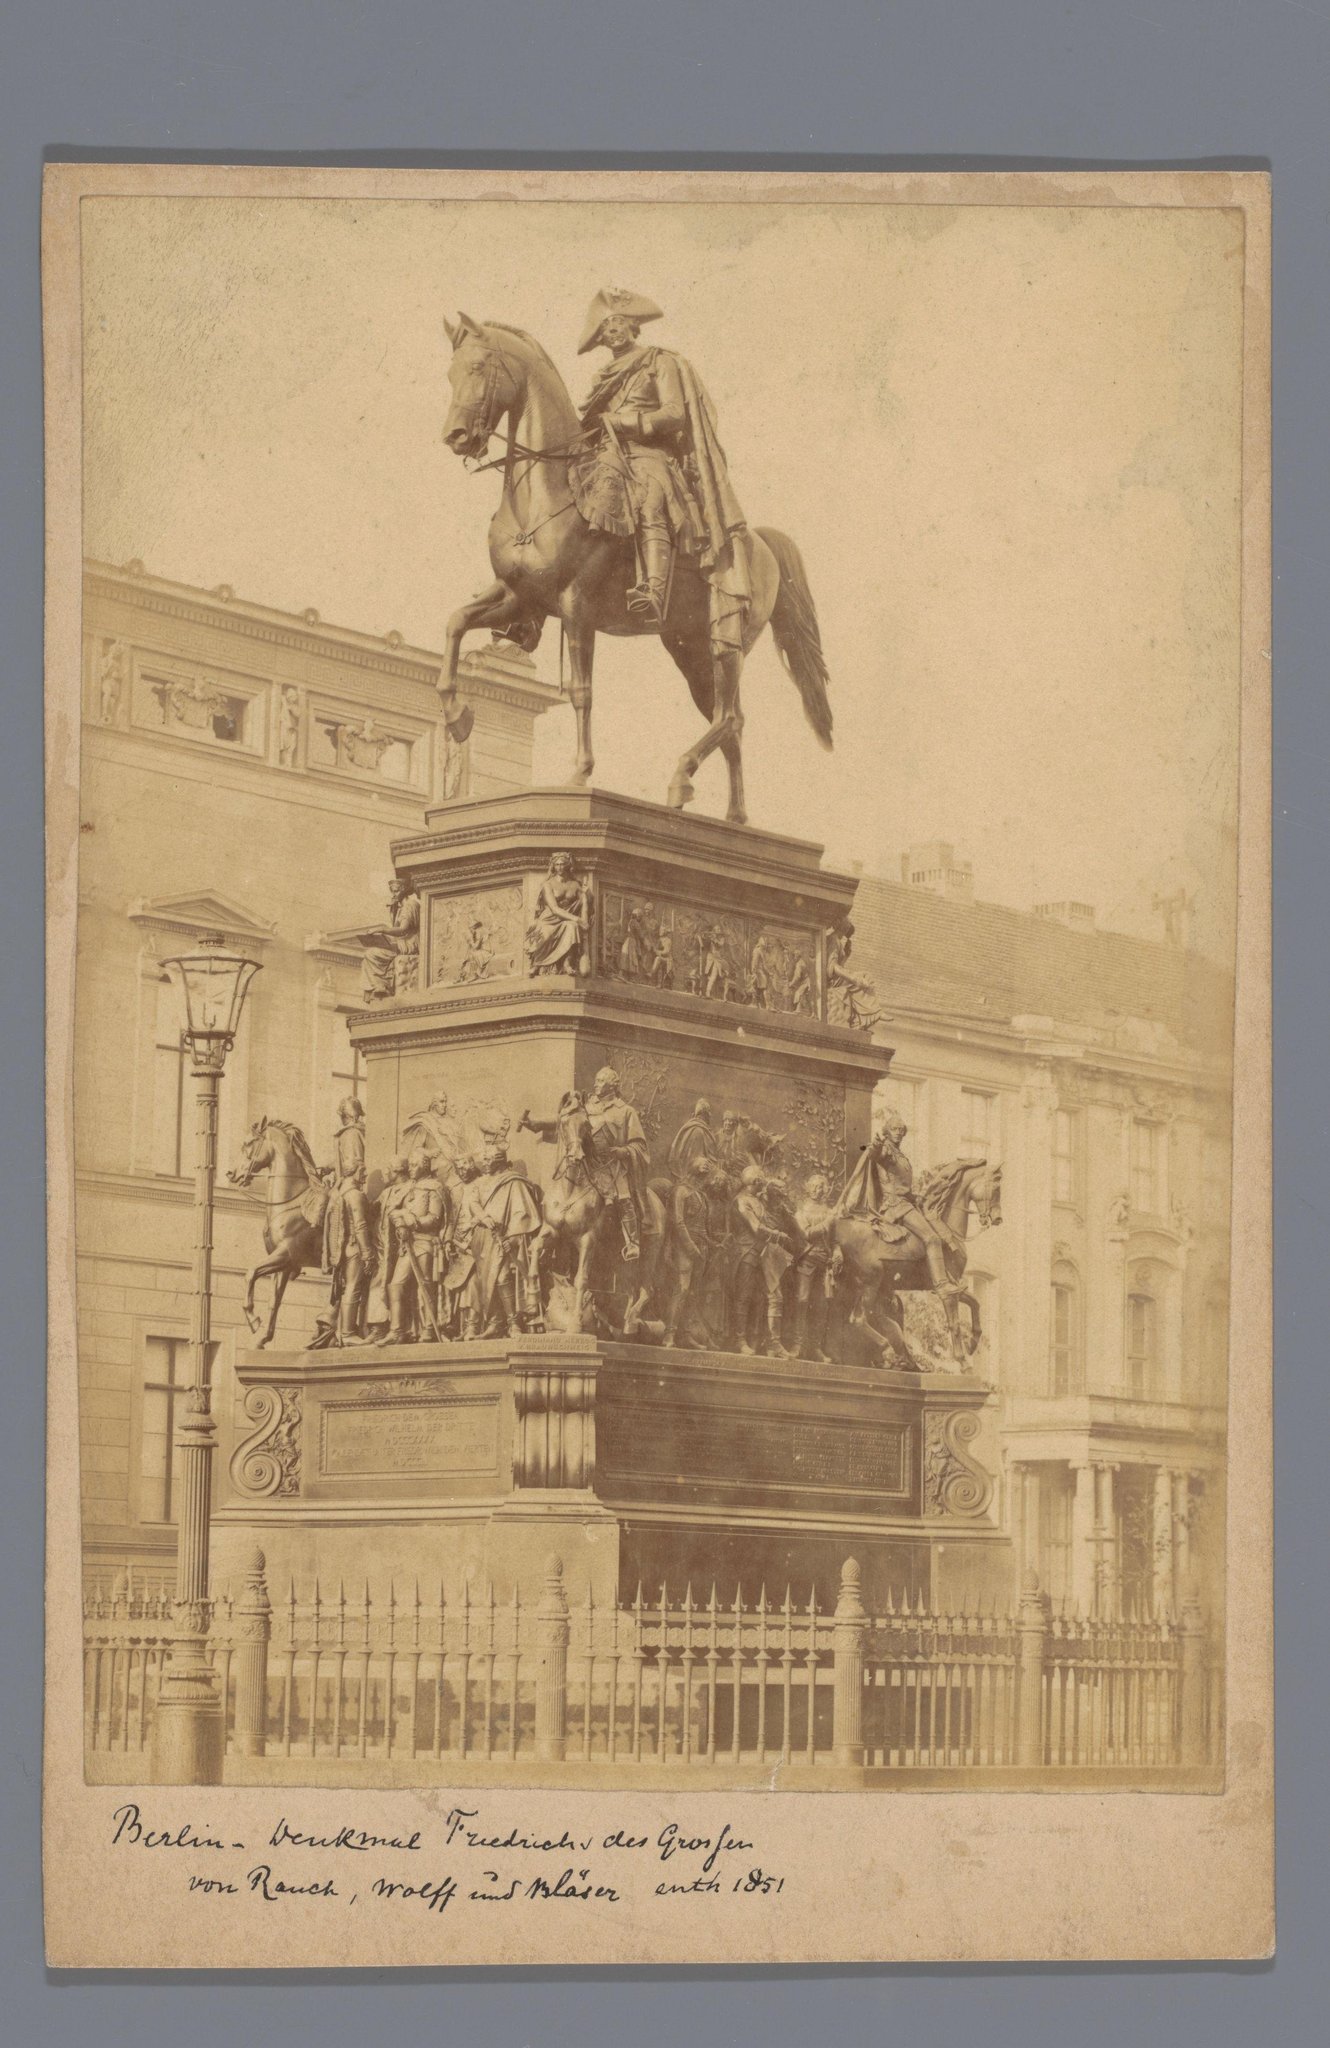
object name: cabinet photograph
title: Ruiterstandbeeld van Frederik de Grote, Unter den Linden, Berlijn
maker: Anonymous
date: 1860-1890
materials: cardboard, paper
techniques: albumen print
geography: berlin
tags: berlin, frederick ii (king of prussia), equestrian statue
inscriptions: inscription: ‘Berlin - Denkmal Friedrich der Grossen/ von Rauch, Wolff und Bläser enth 1851’